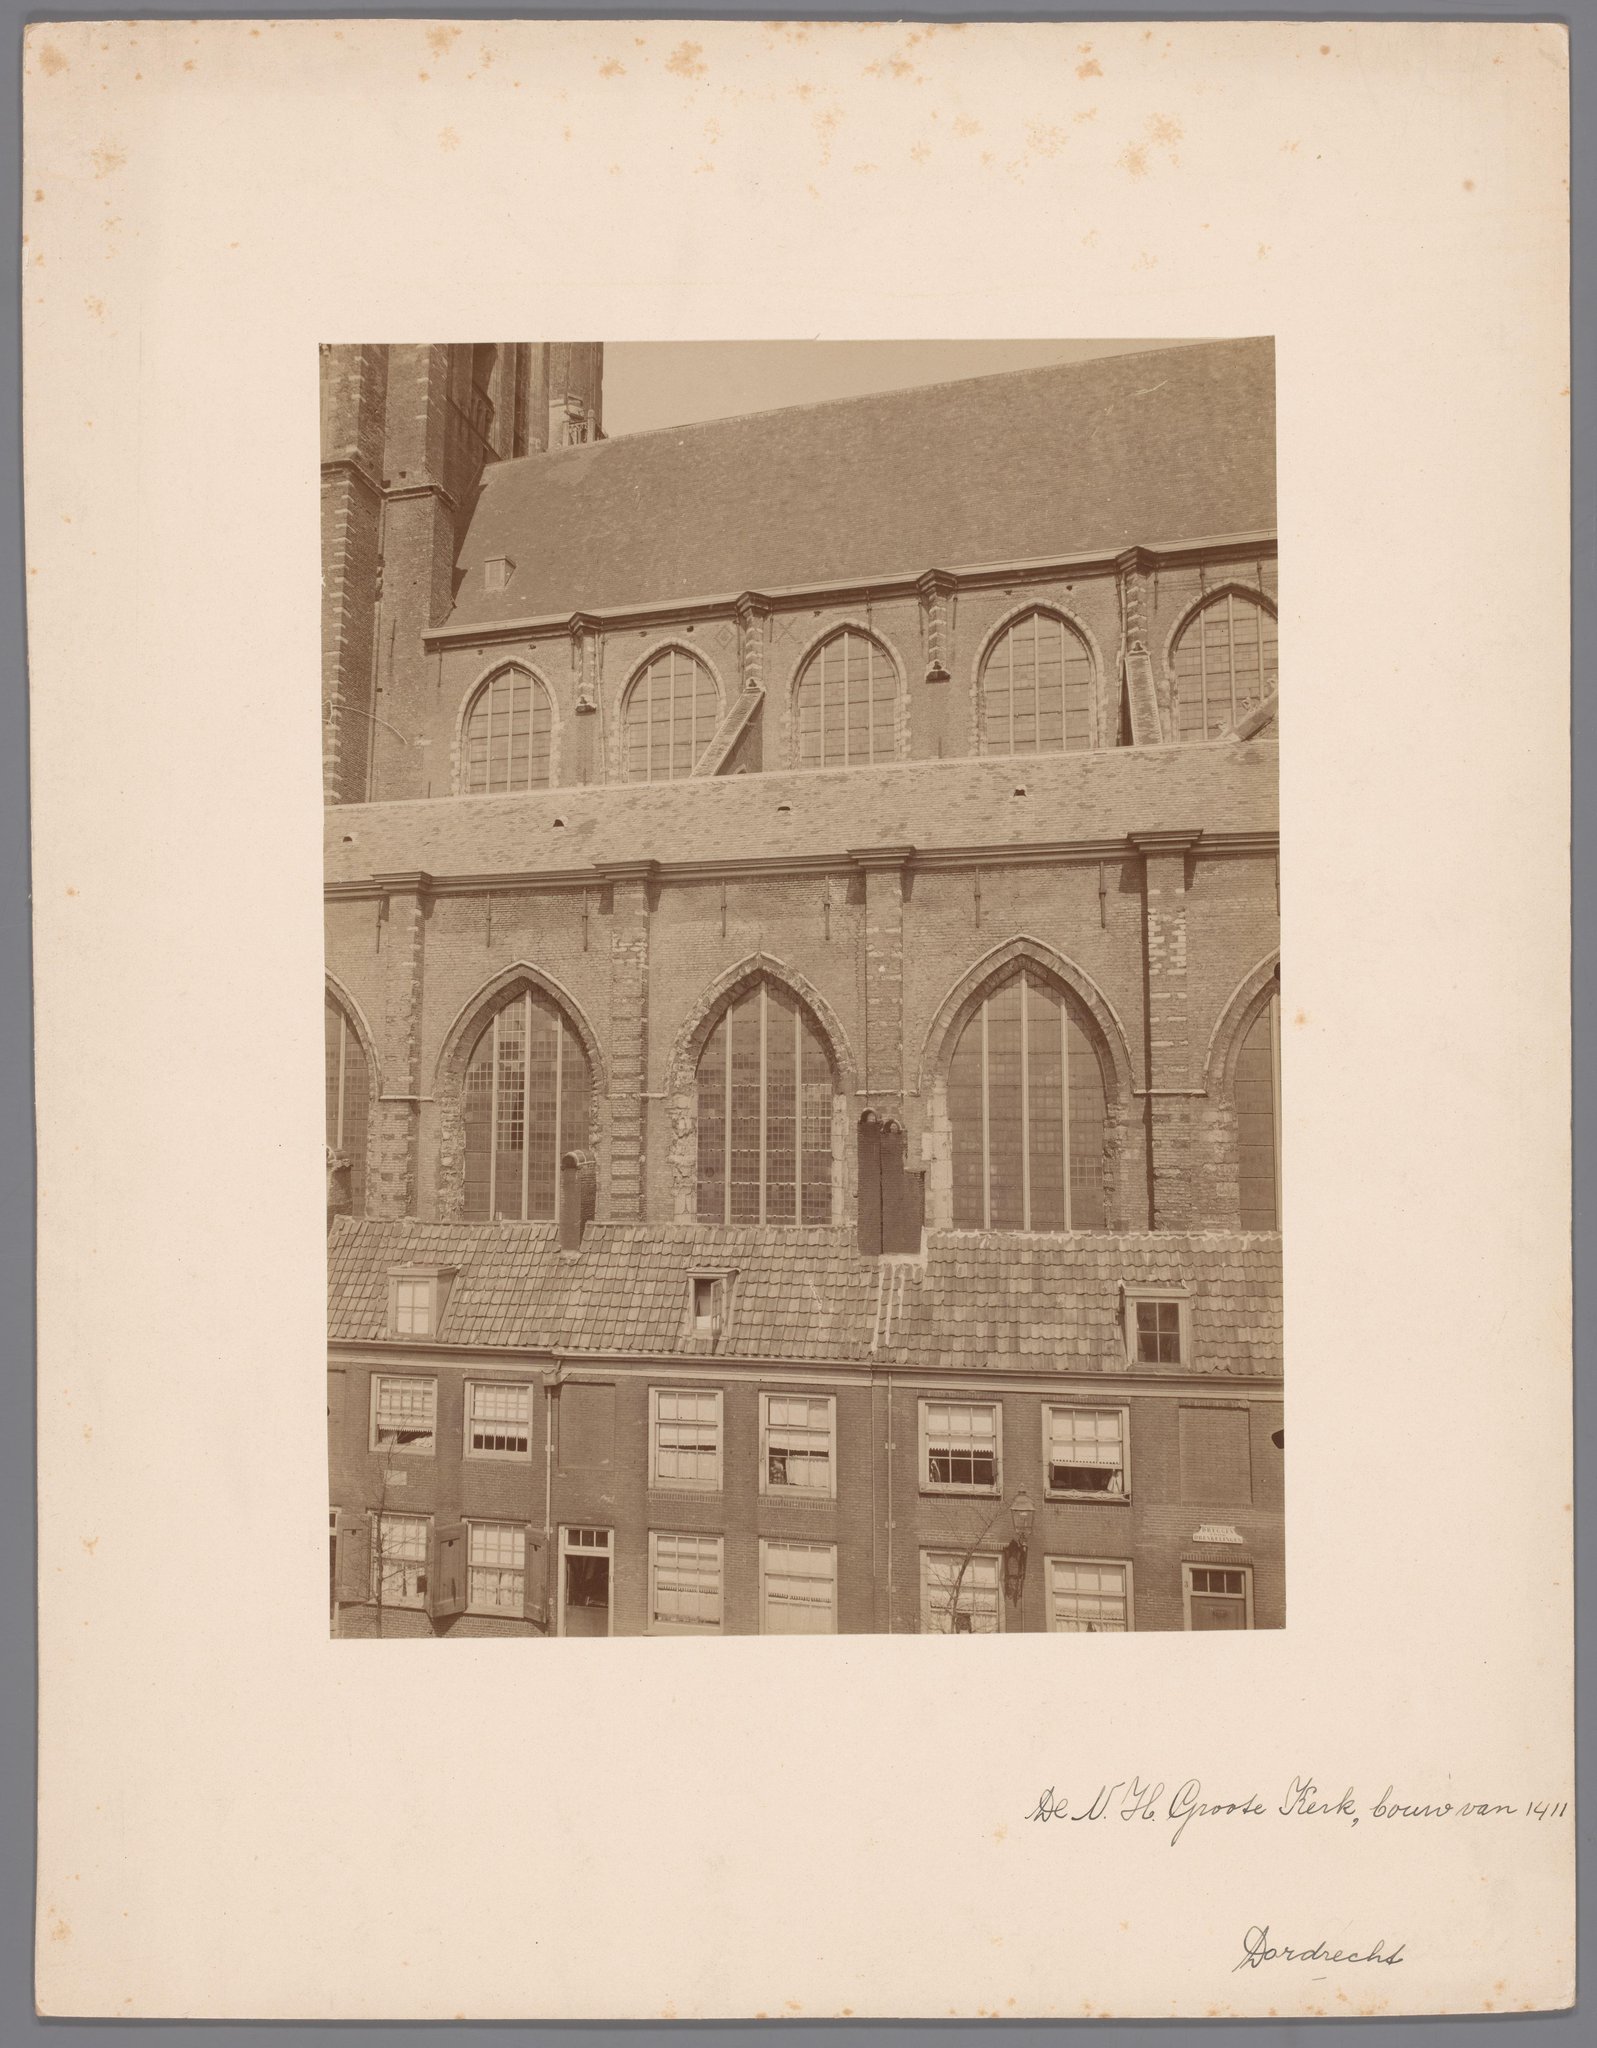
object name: photograph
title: Zijaanzicht van de Grote of Onze-Lieve-Vrouwenkerk te Dordrecht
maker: anoniem (monumentenzorg)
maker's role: fotograaf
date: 1880-1910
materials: cardboard, photographic support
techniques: albumen print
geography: dordrecht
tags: church (exterior)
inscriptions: annotation: ‘De N.H. Groote Kerk, bouw van 1411/ Dordrecht’, annotation: ‘Kerk der N.H. gemeente te Dordrecht (Z.H.)/ Bouw van 1411’